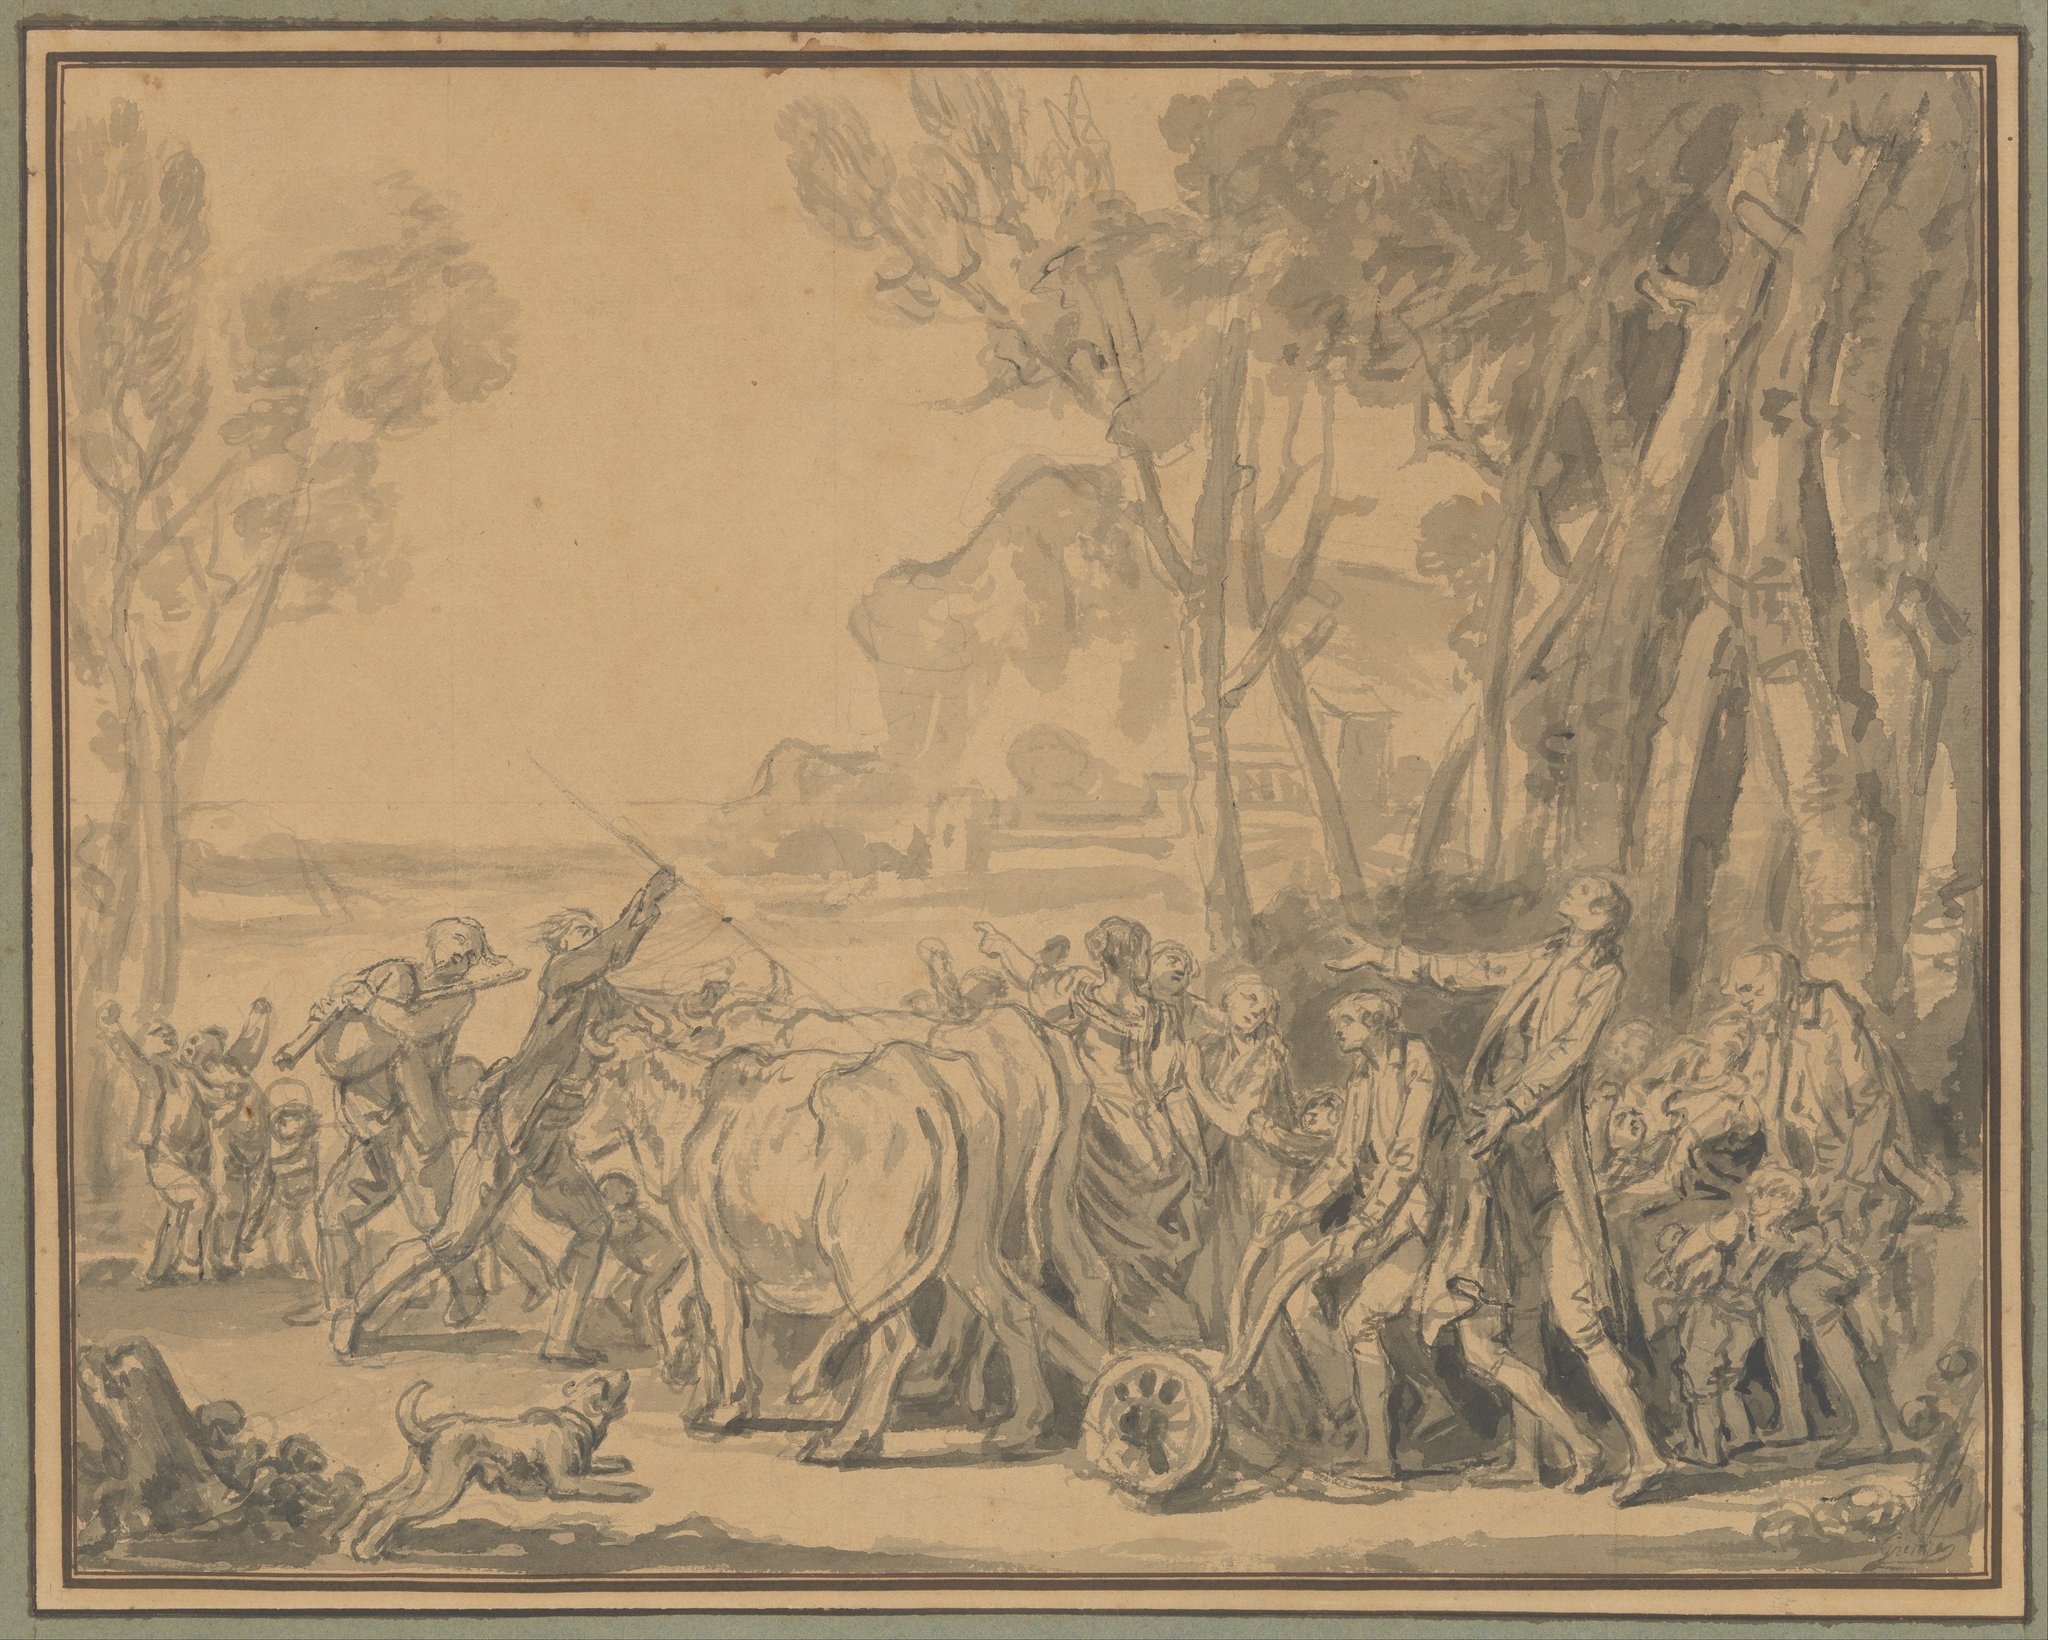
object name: drawing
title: A Farmer Entrusting the Plow to His Son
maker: jean-baptiste greuze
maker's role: artist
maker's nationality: french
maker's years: 1725-1805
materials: graphite, ink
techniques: brush, pen, drawing, wash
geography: france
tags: cows,dogs,trees,farmers